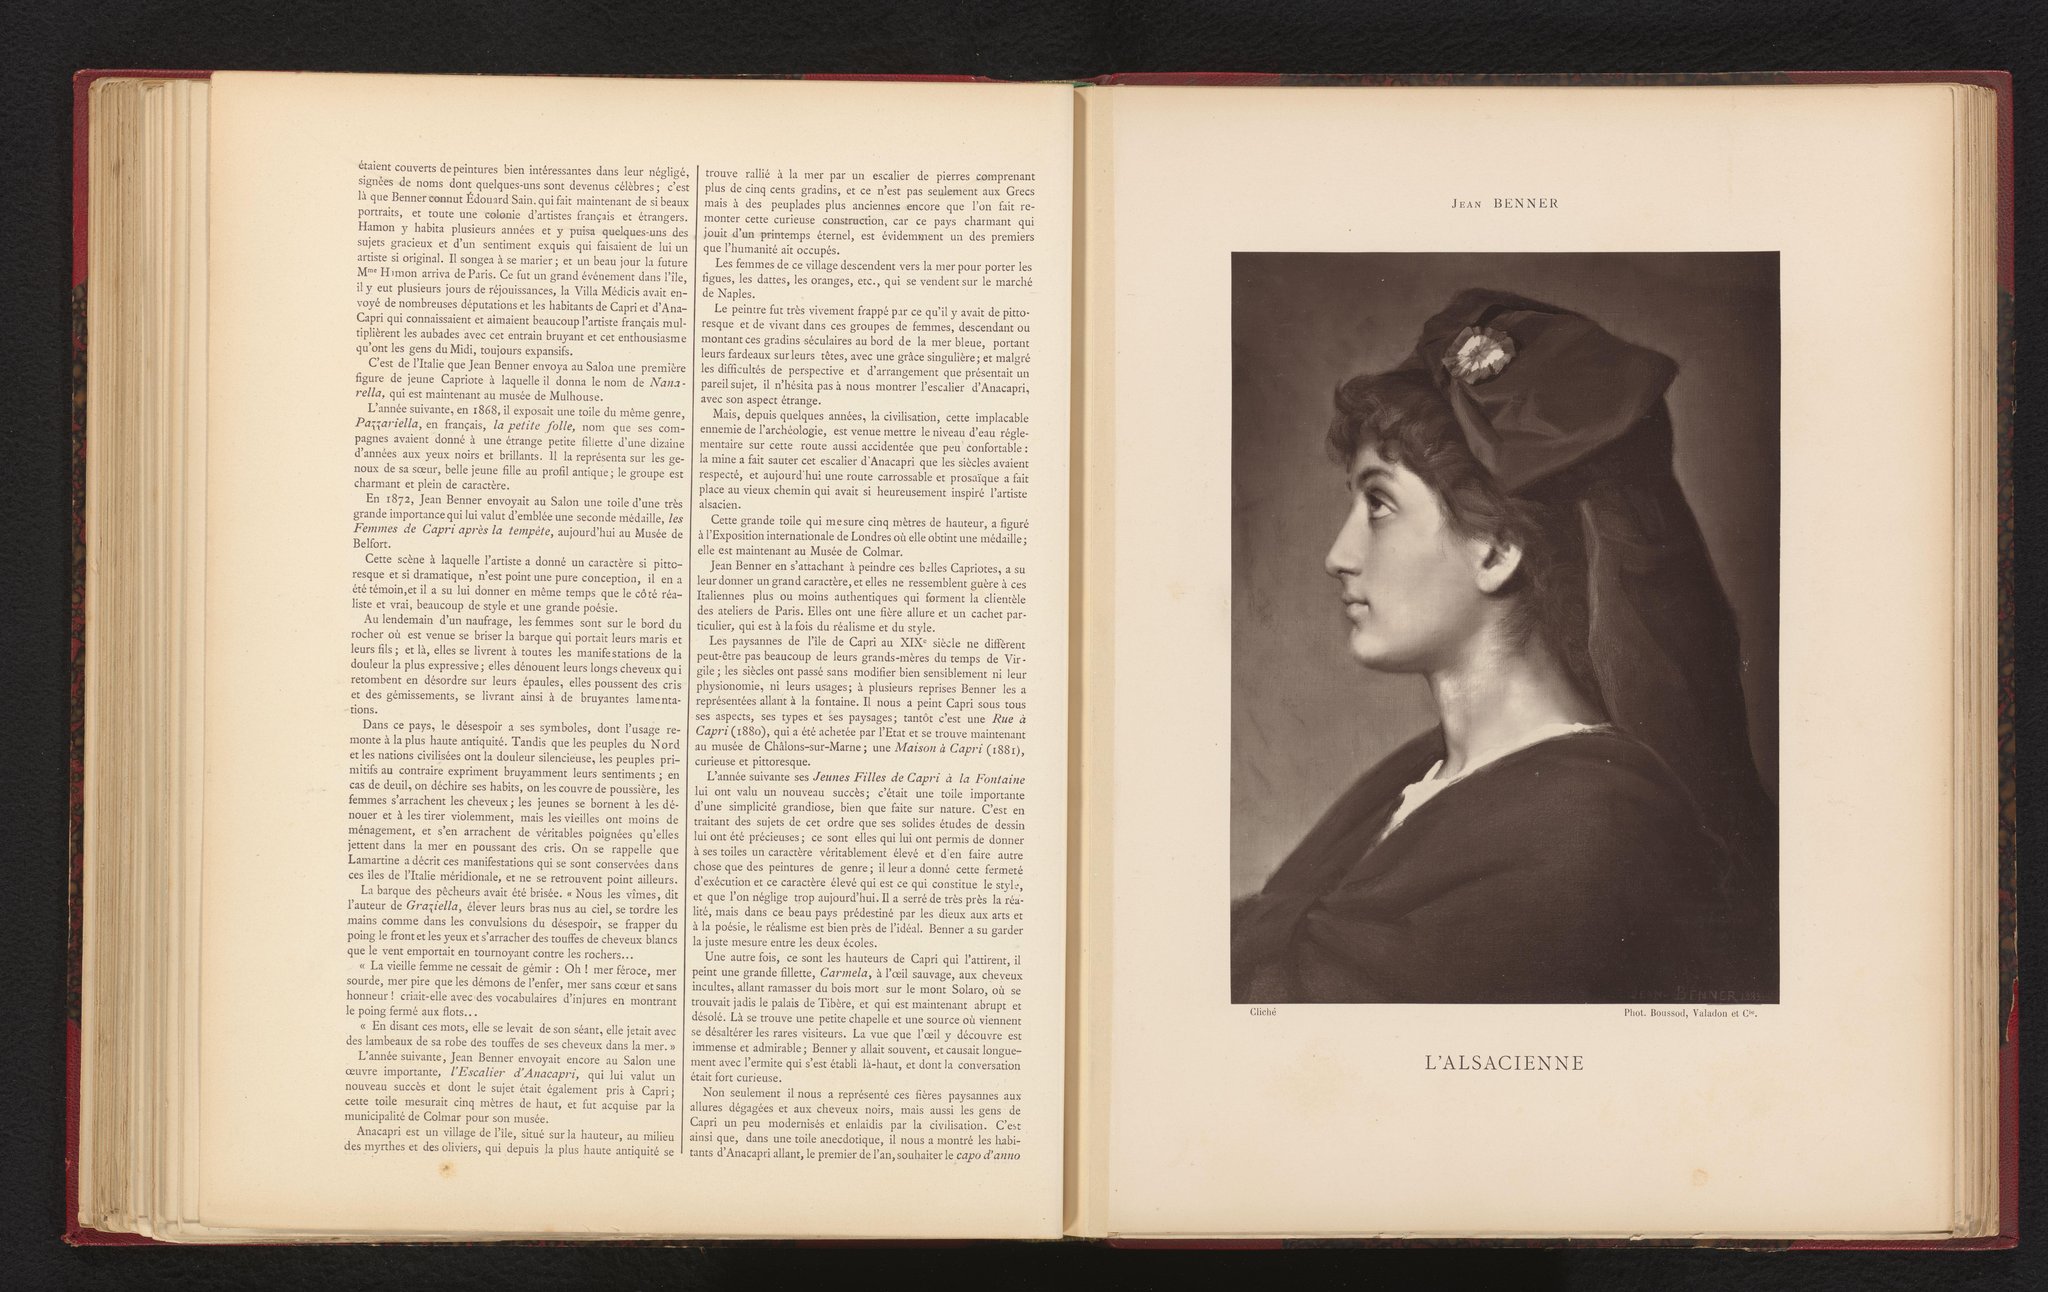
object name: page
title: Fotoreproductie van het schilderij 'L'Alsacienne' door Jean Benner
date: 1883-1884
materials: paper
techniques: woodburytype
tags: adult woman